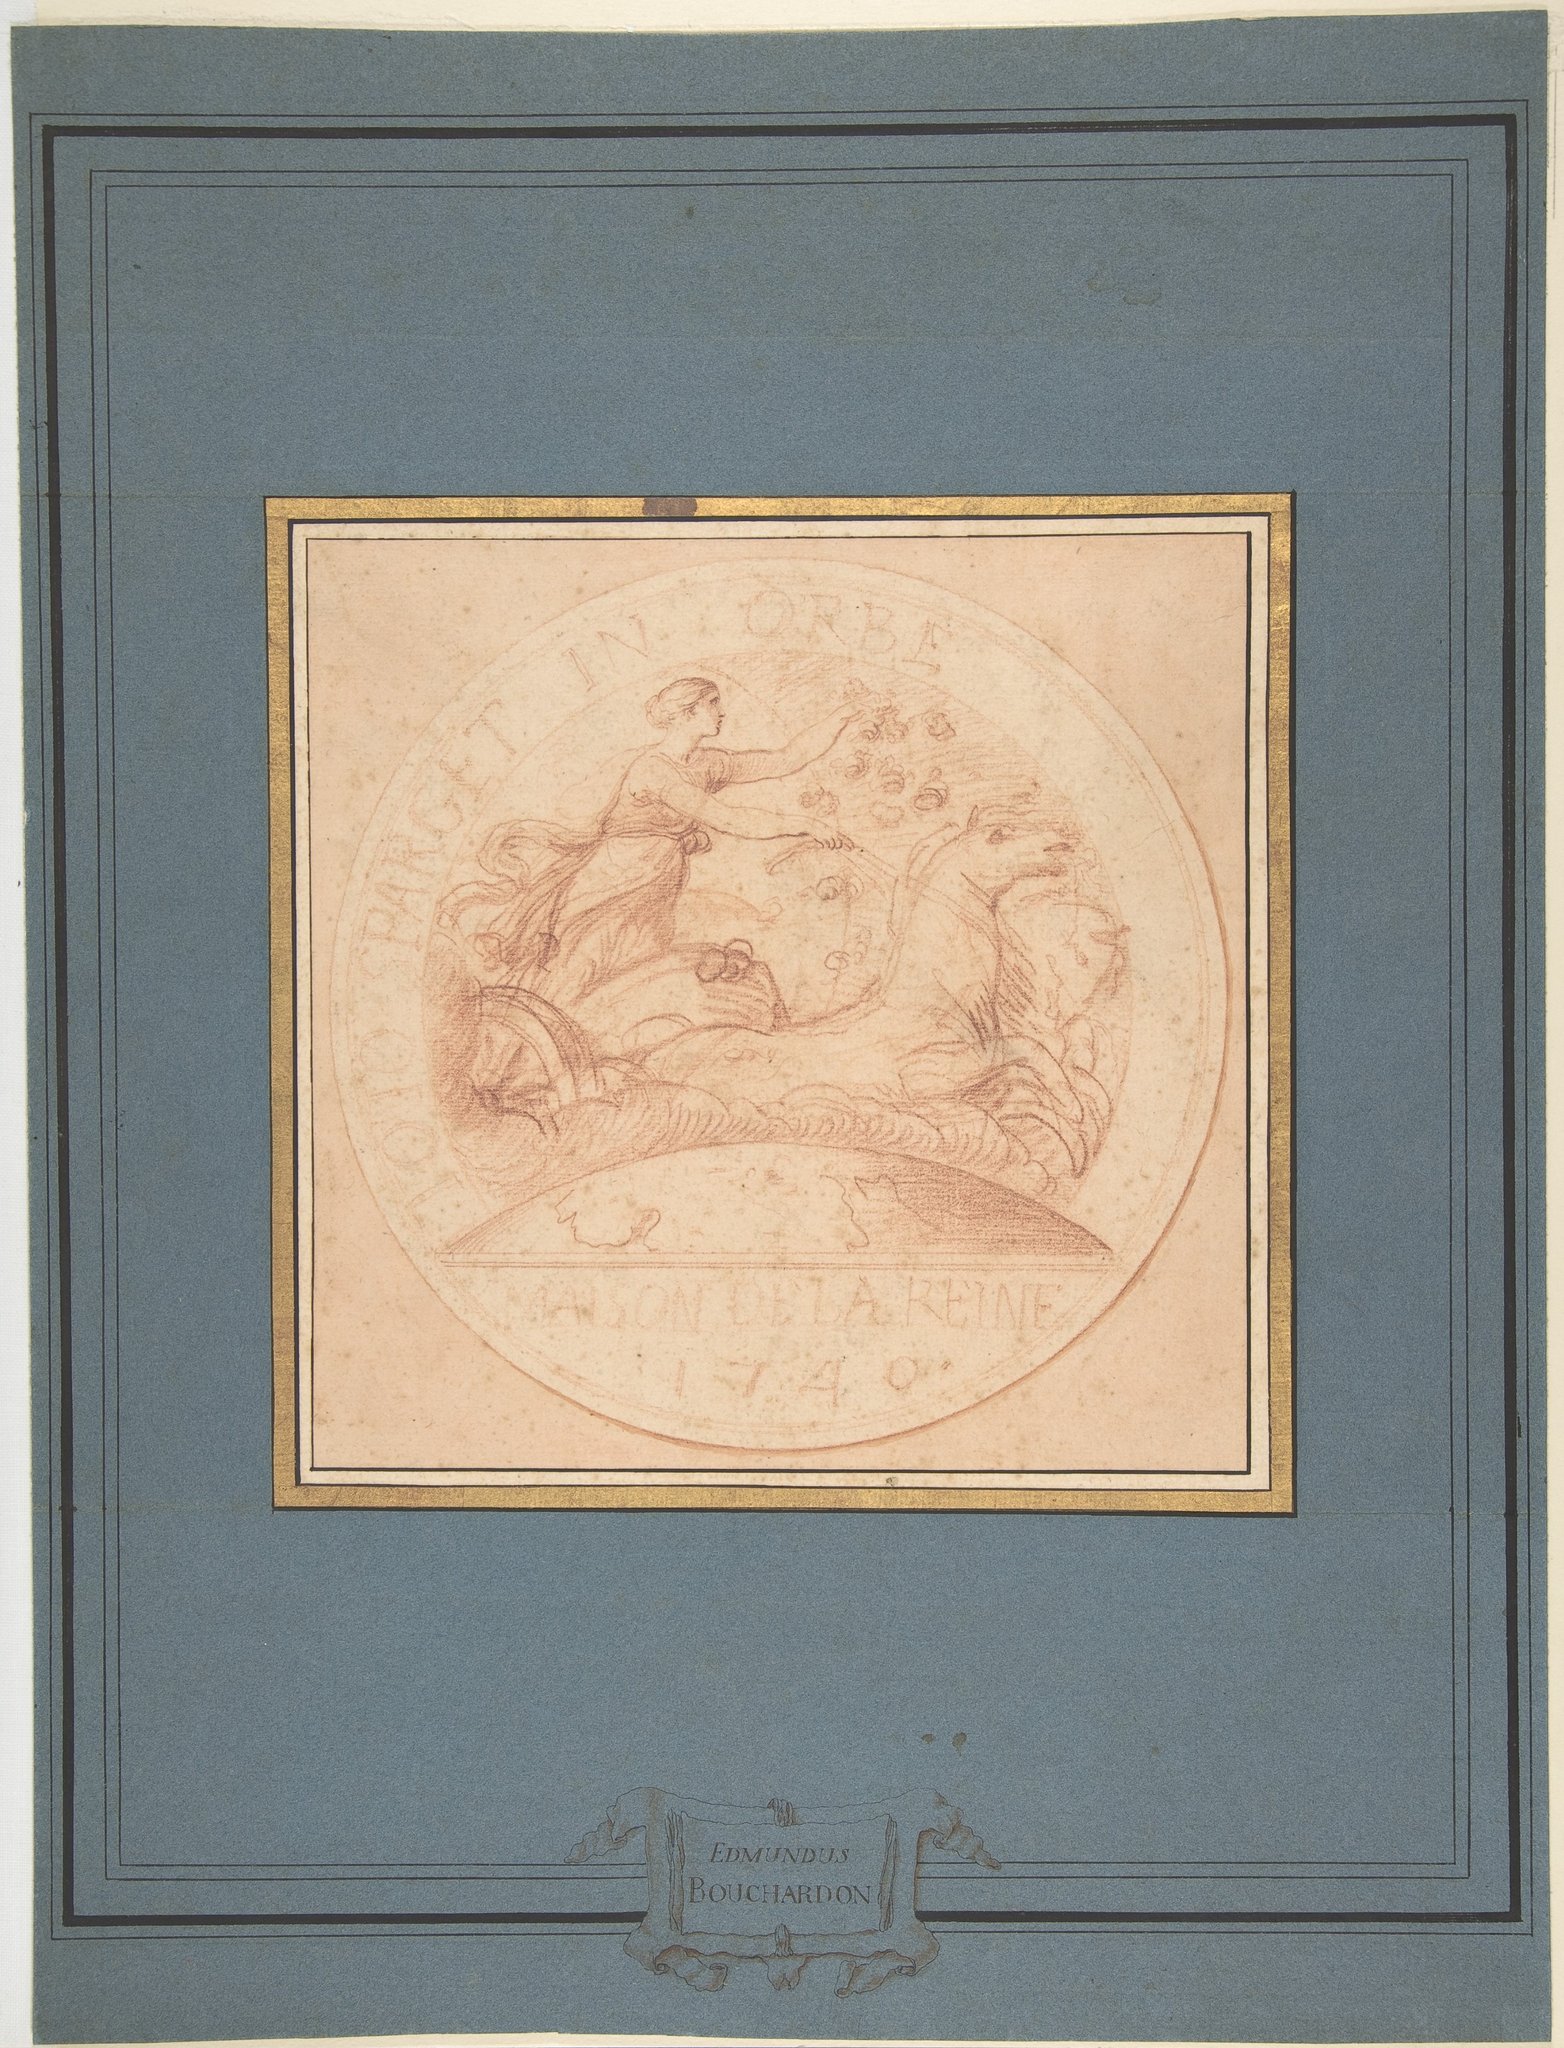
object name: drawing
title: Design for a jeton or a token: Maison de la Reine 1740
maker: edme bouchardon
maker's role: artist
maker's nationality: french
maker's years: 1698-1762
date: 1740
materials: chalk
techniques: wash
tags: women,horses,chariots